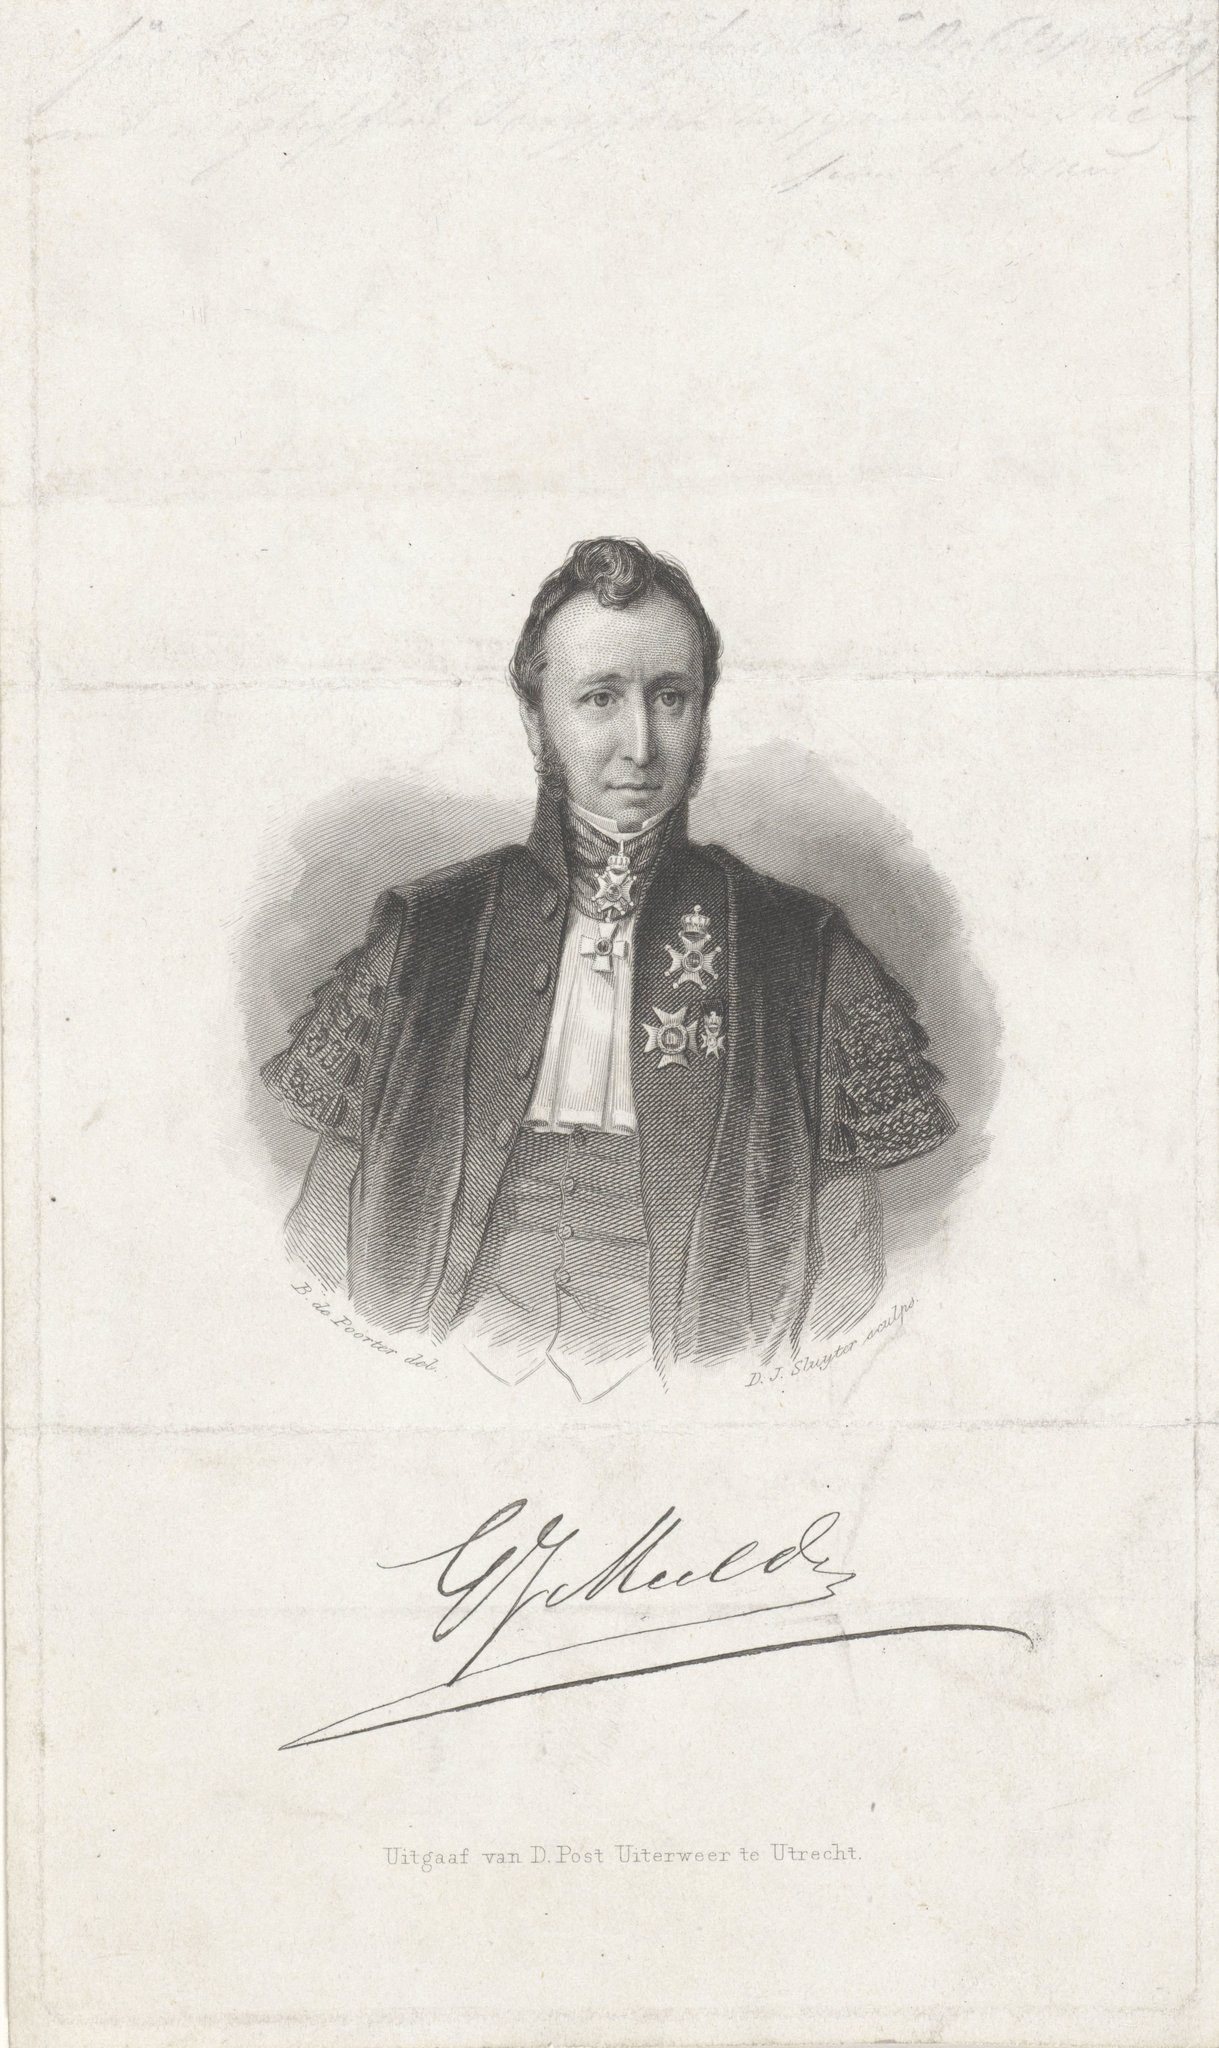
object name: print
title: Portret van de chemicus Gerardus Johannes Mulder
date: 1848-1863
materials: paper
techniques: etching, engraving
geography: utrecht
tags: utrecht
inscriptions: collector's mark: Lugt 2228